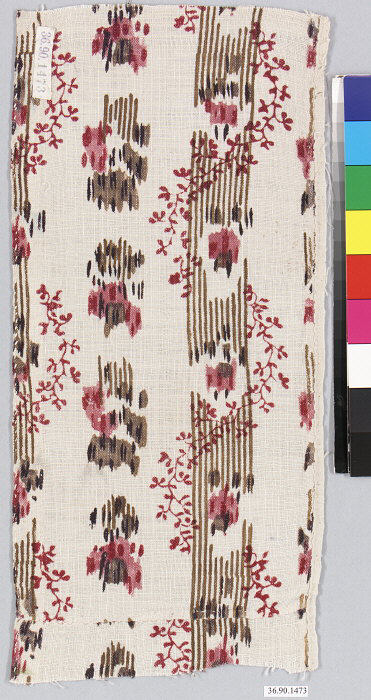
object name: piece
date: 1701-1800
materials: cotton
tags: leaves